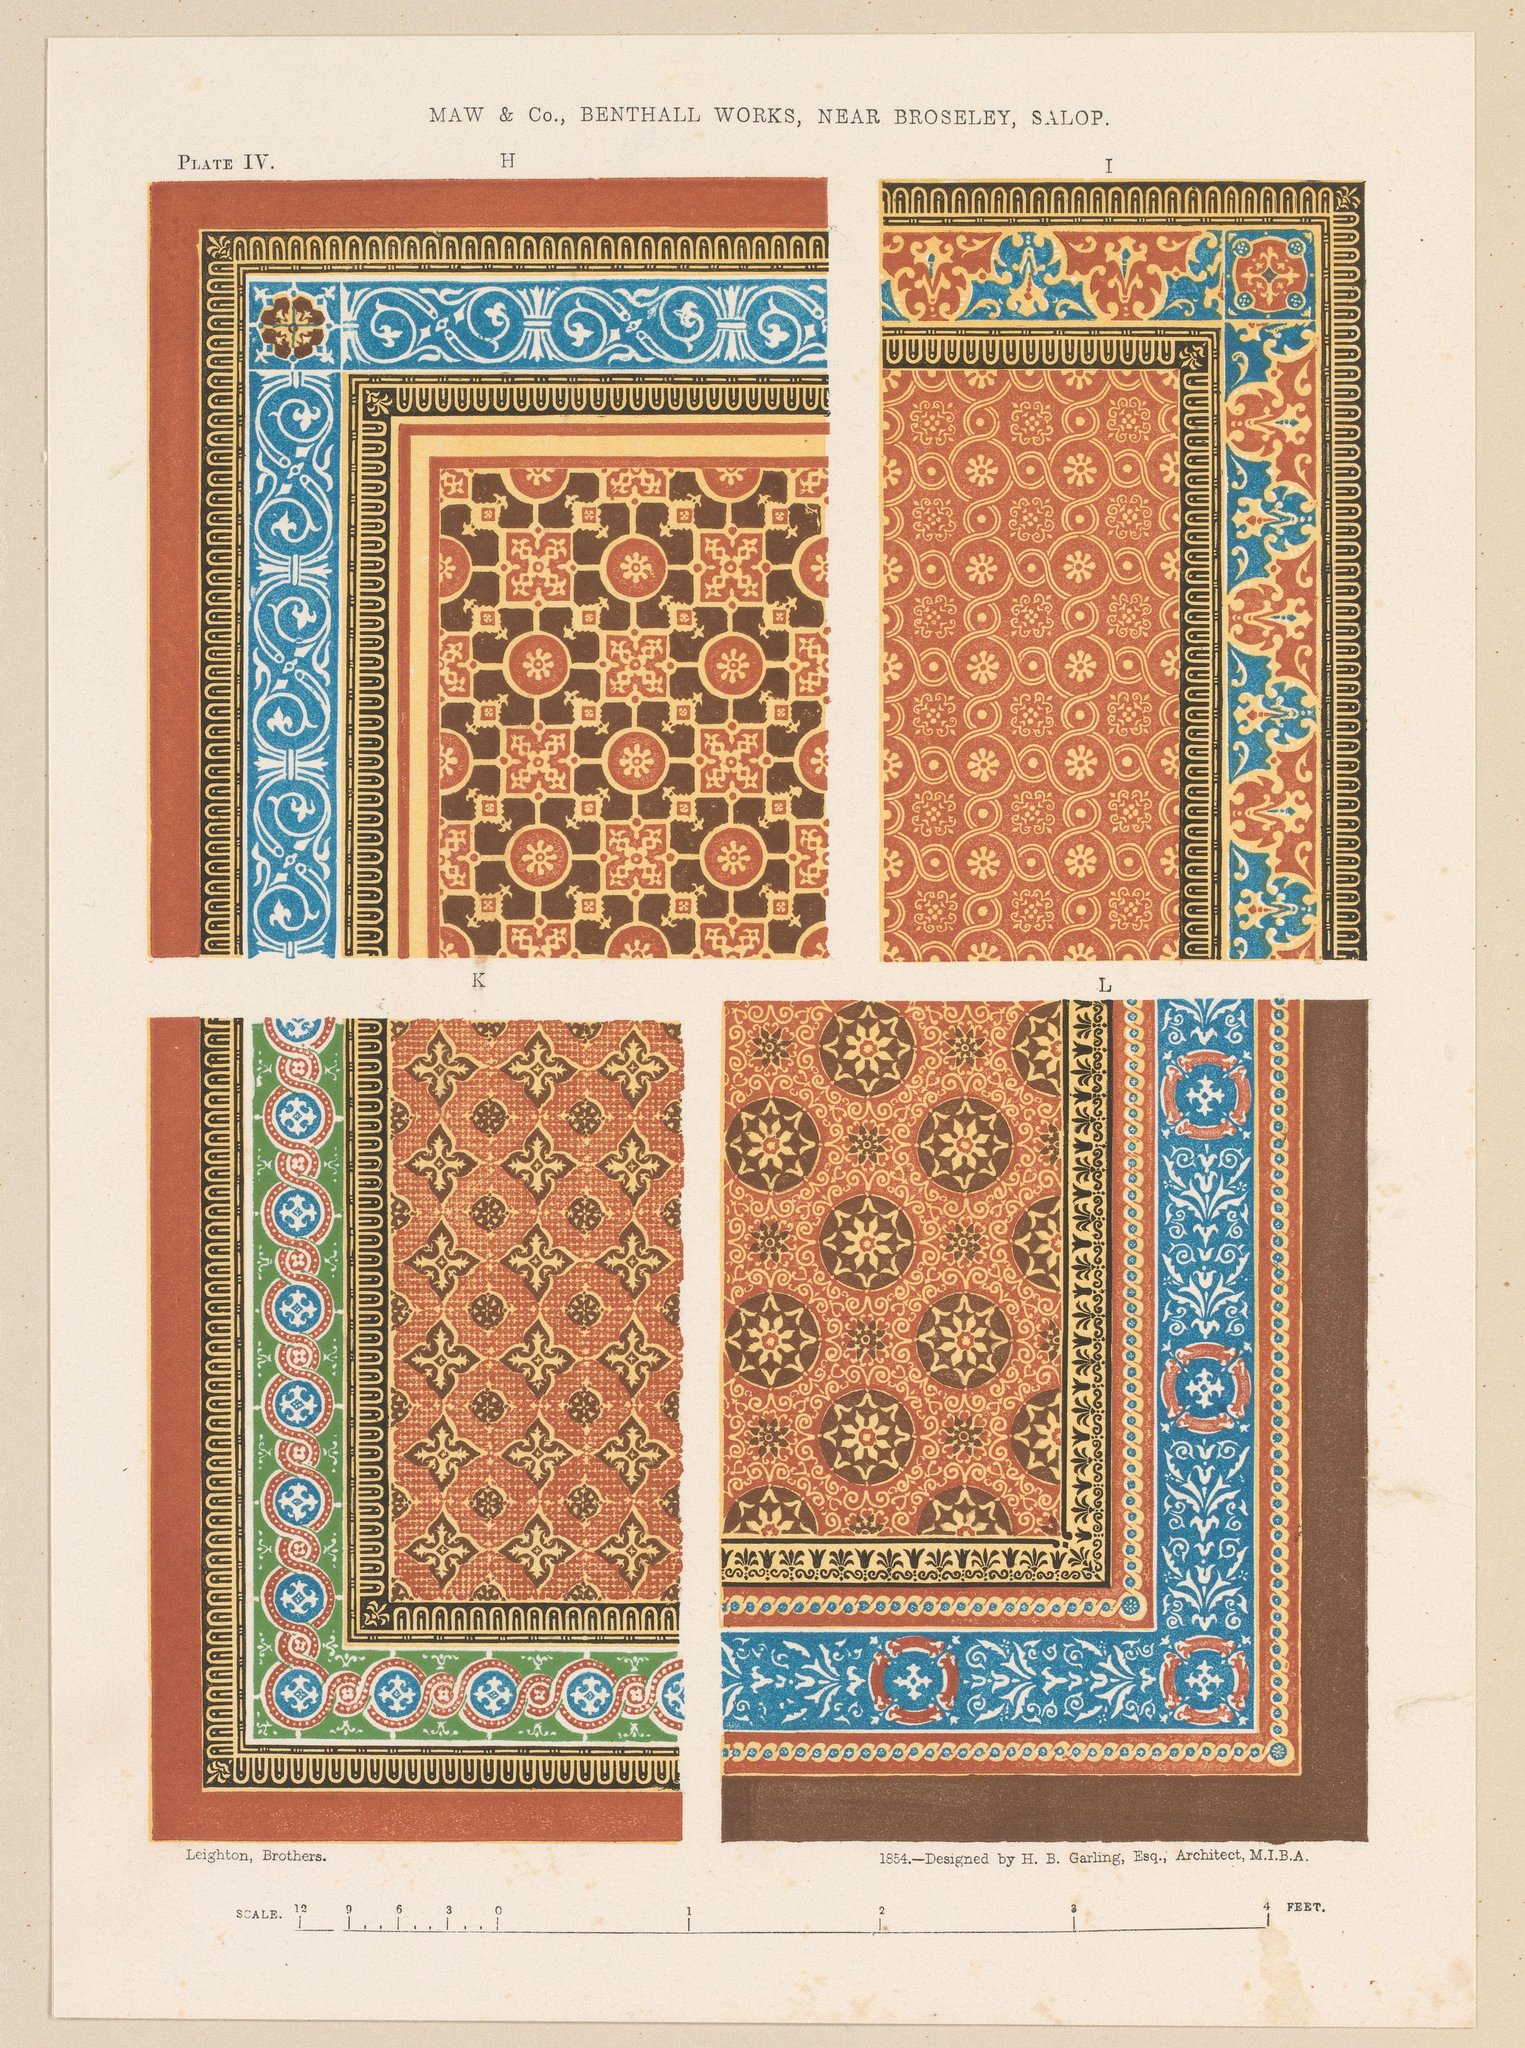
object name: print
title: Decoratiepatronen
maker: henry bayly garling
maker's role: designer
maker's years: 1822-1909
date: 1854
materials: paper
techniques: chromolithography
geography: england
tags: ornament ~ geometric motifs, tiles, bricks ~ building material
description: Patronen voor tegels. Plate IV. Geproduceerd door 'Maw & Co, Benthall Works, near Broseley, Salop'.